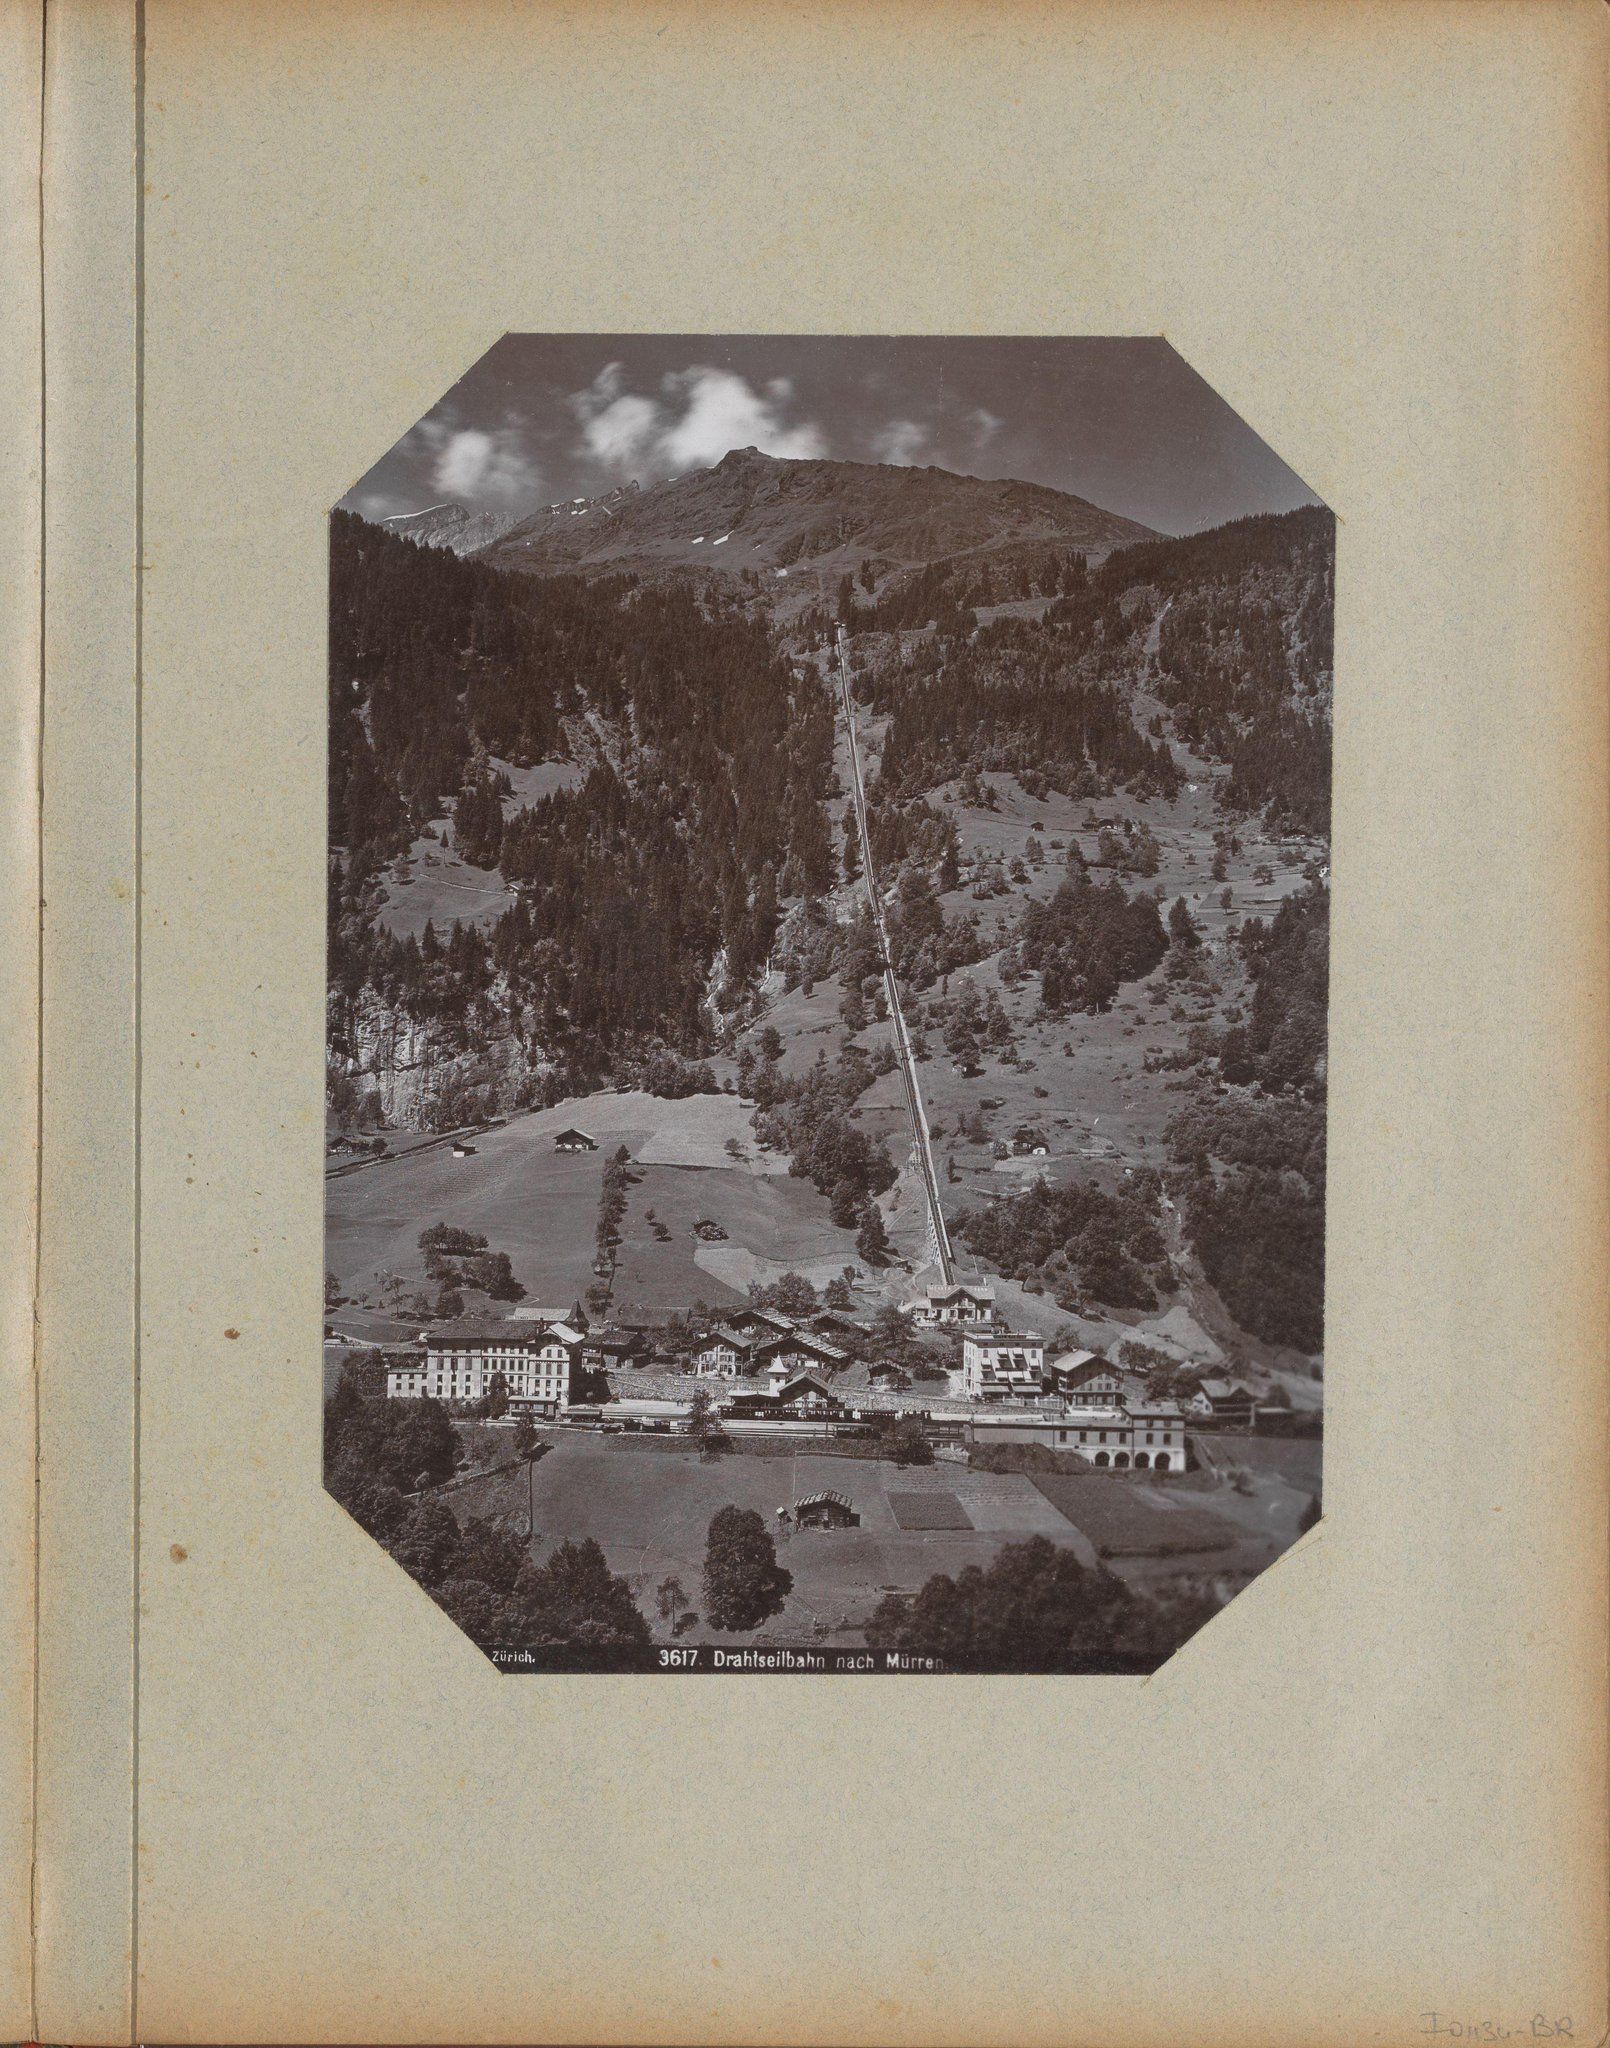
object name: album leaf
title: Drahtseilbahn nach Mürren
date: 1880-1910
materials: paper, photographic support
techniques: collodion silver print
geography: mürren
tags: funicular railway, mountain-range, snow peaks, station; shelter (railway, tramway)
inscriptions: number: ‘3617’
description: Onderdeel van Reisalbum met bezienswaardigheden in Engeland, Zwitserland, Frankrijk en Duitsland.